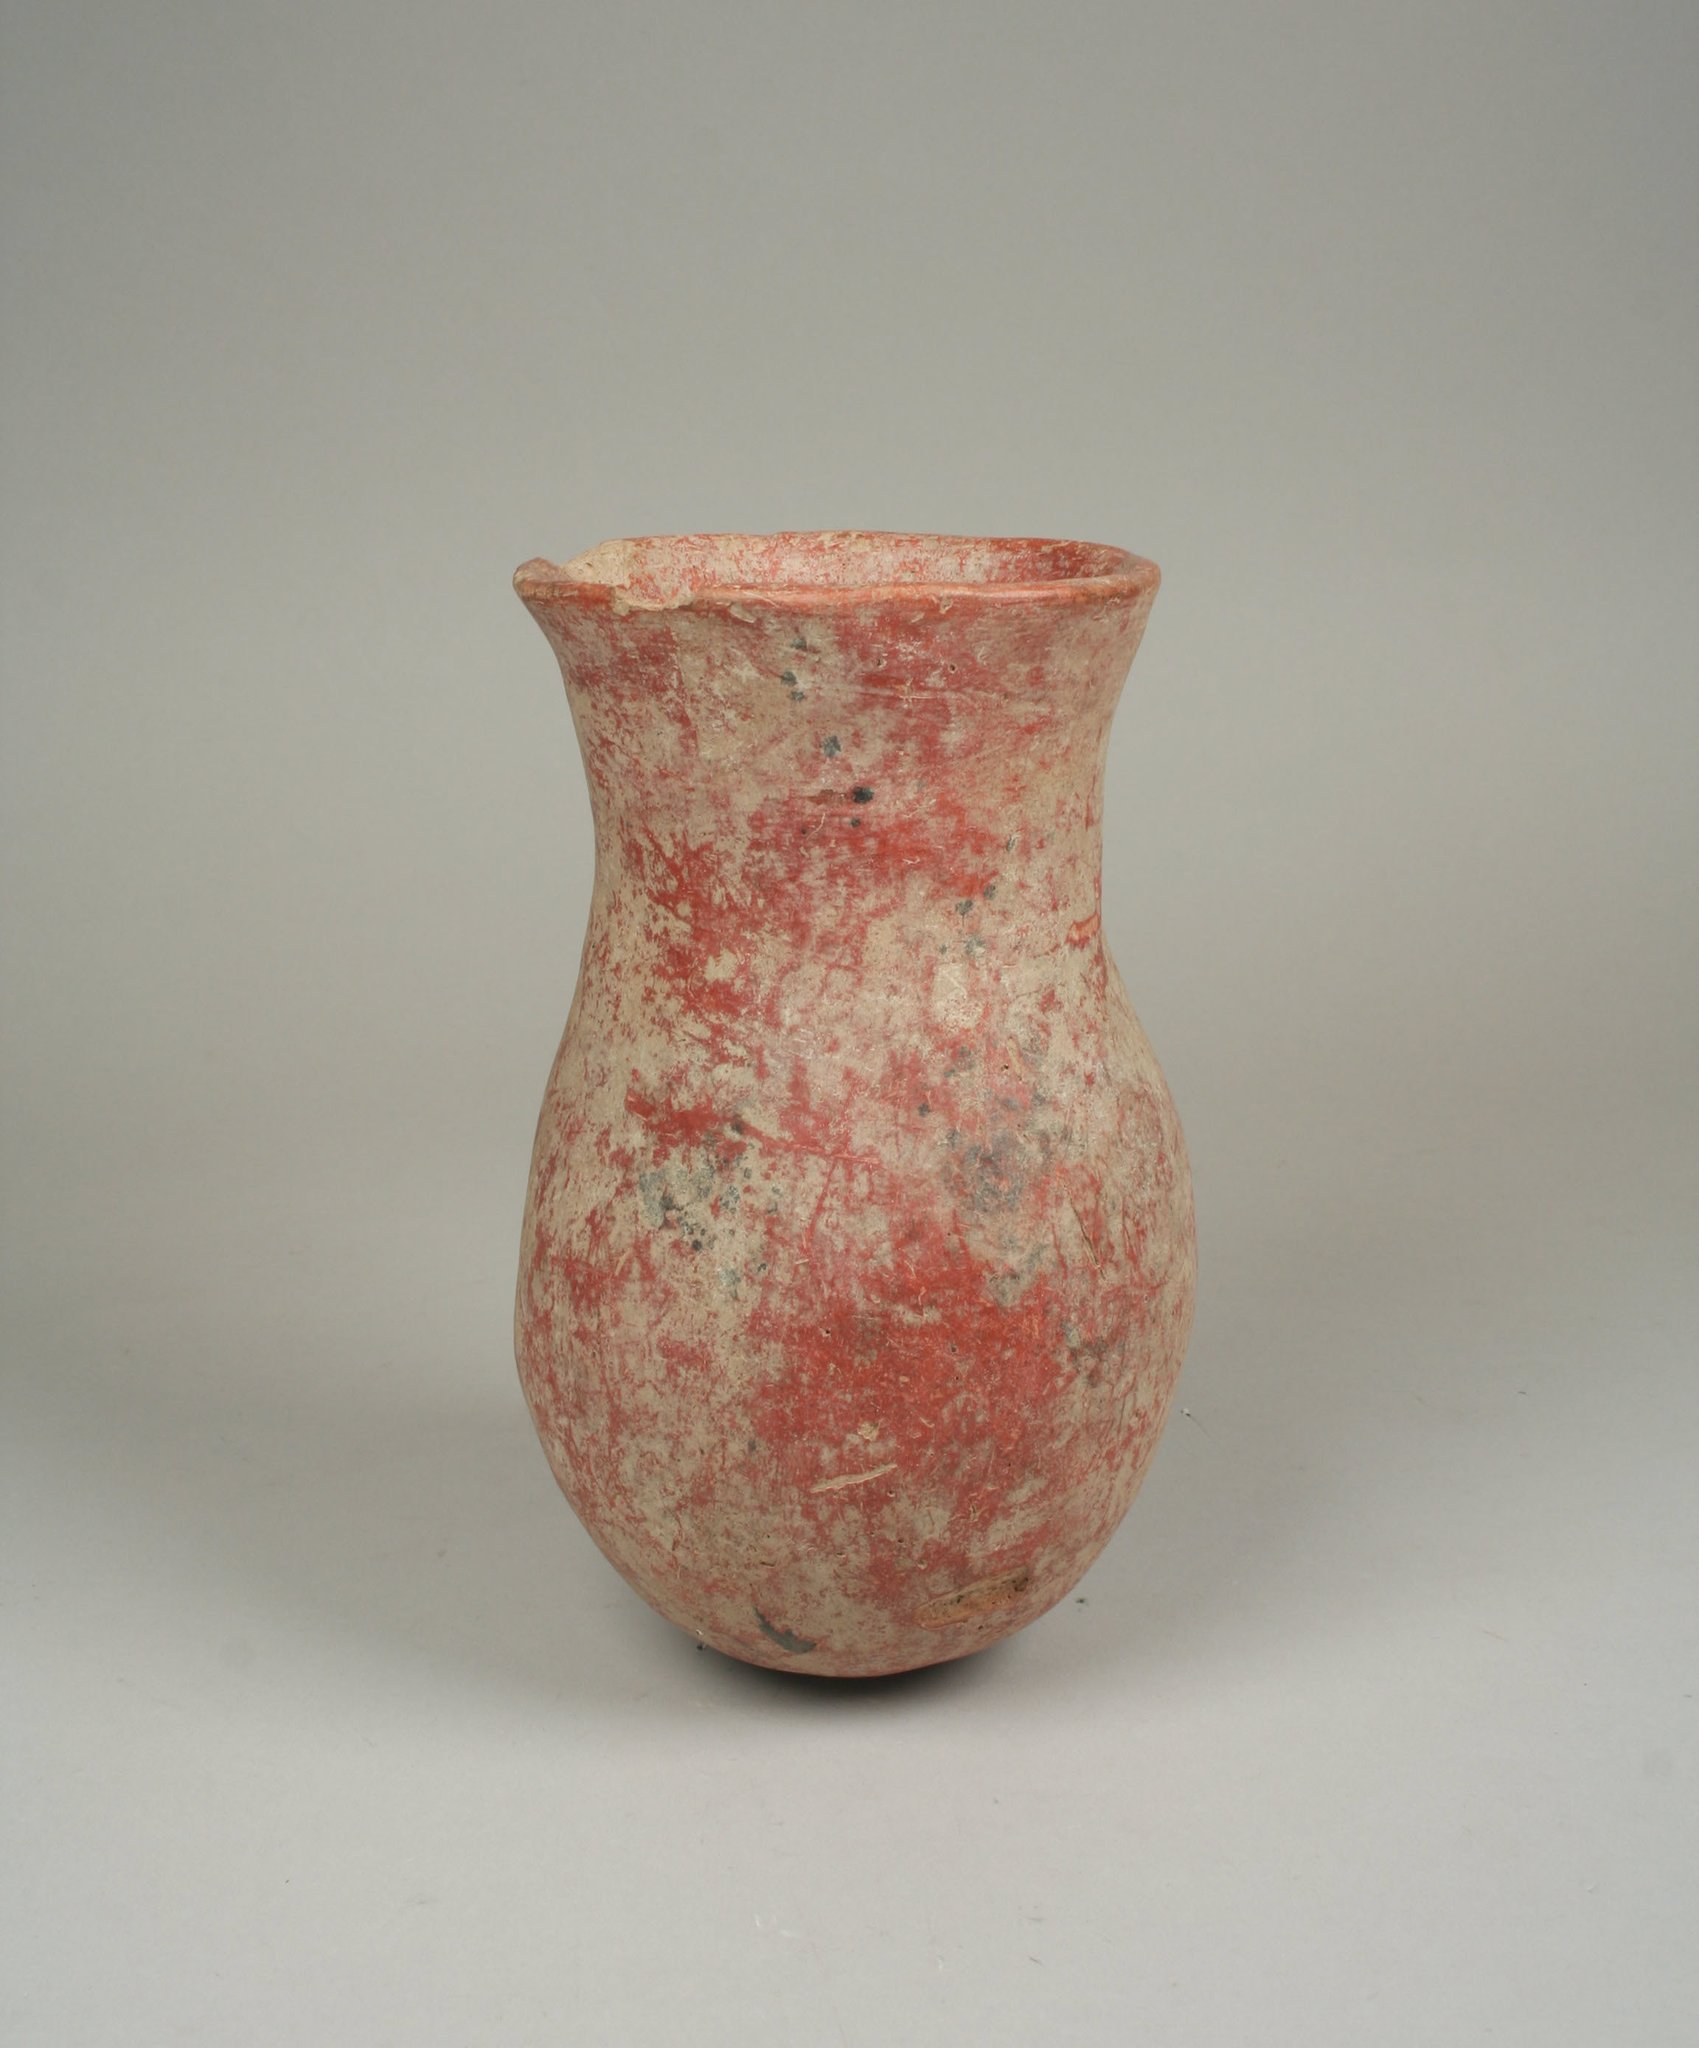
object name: vessel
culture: middle niger civilization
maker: middle niger artist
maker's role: artist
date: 1101-1600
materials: terracotta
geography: mali